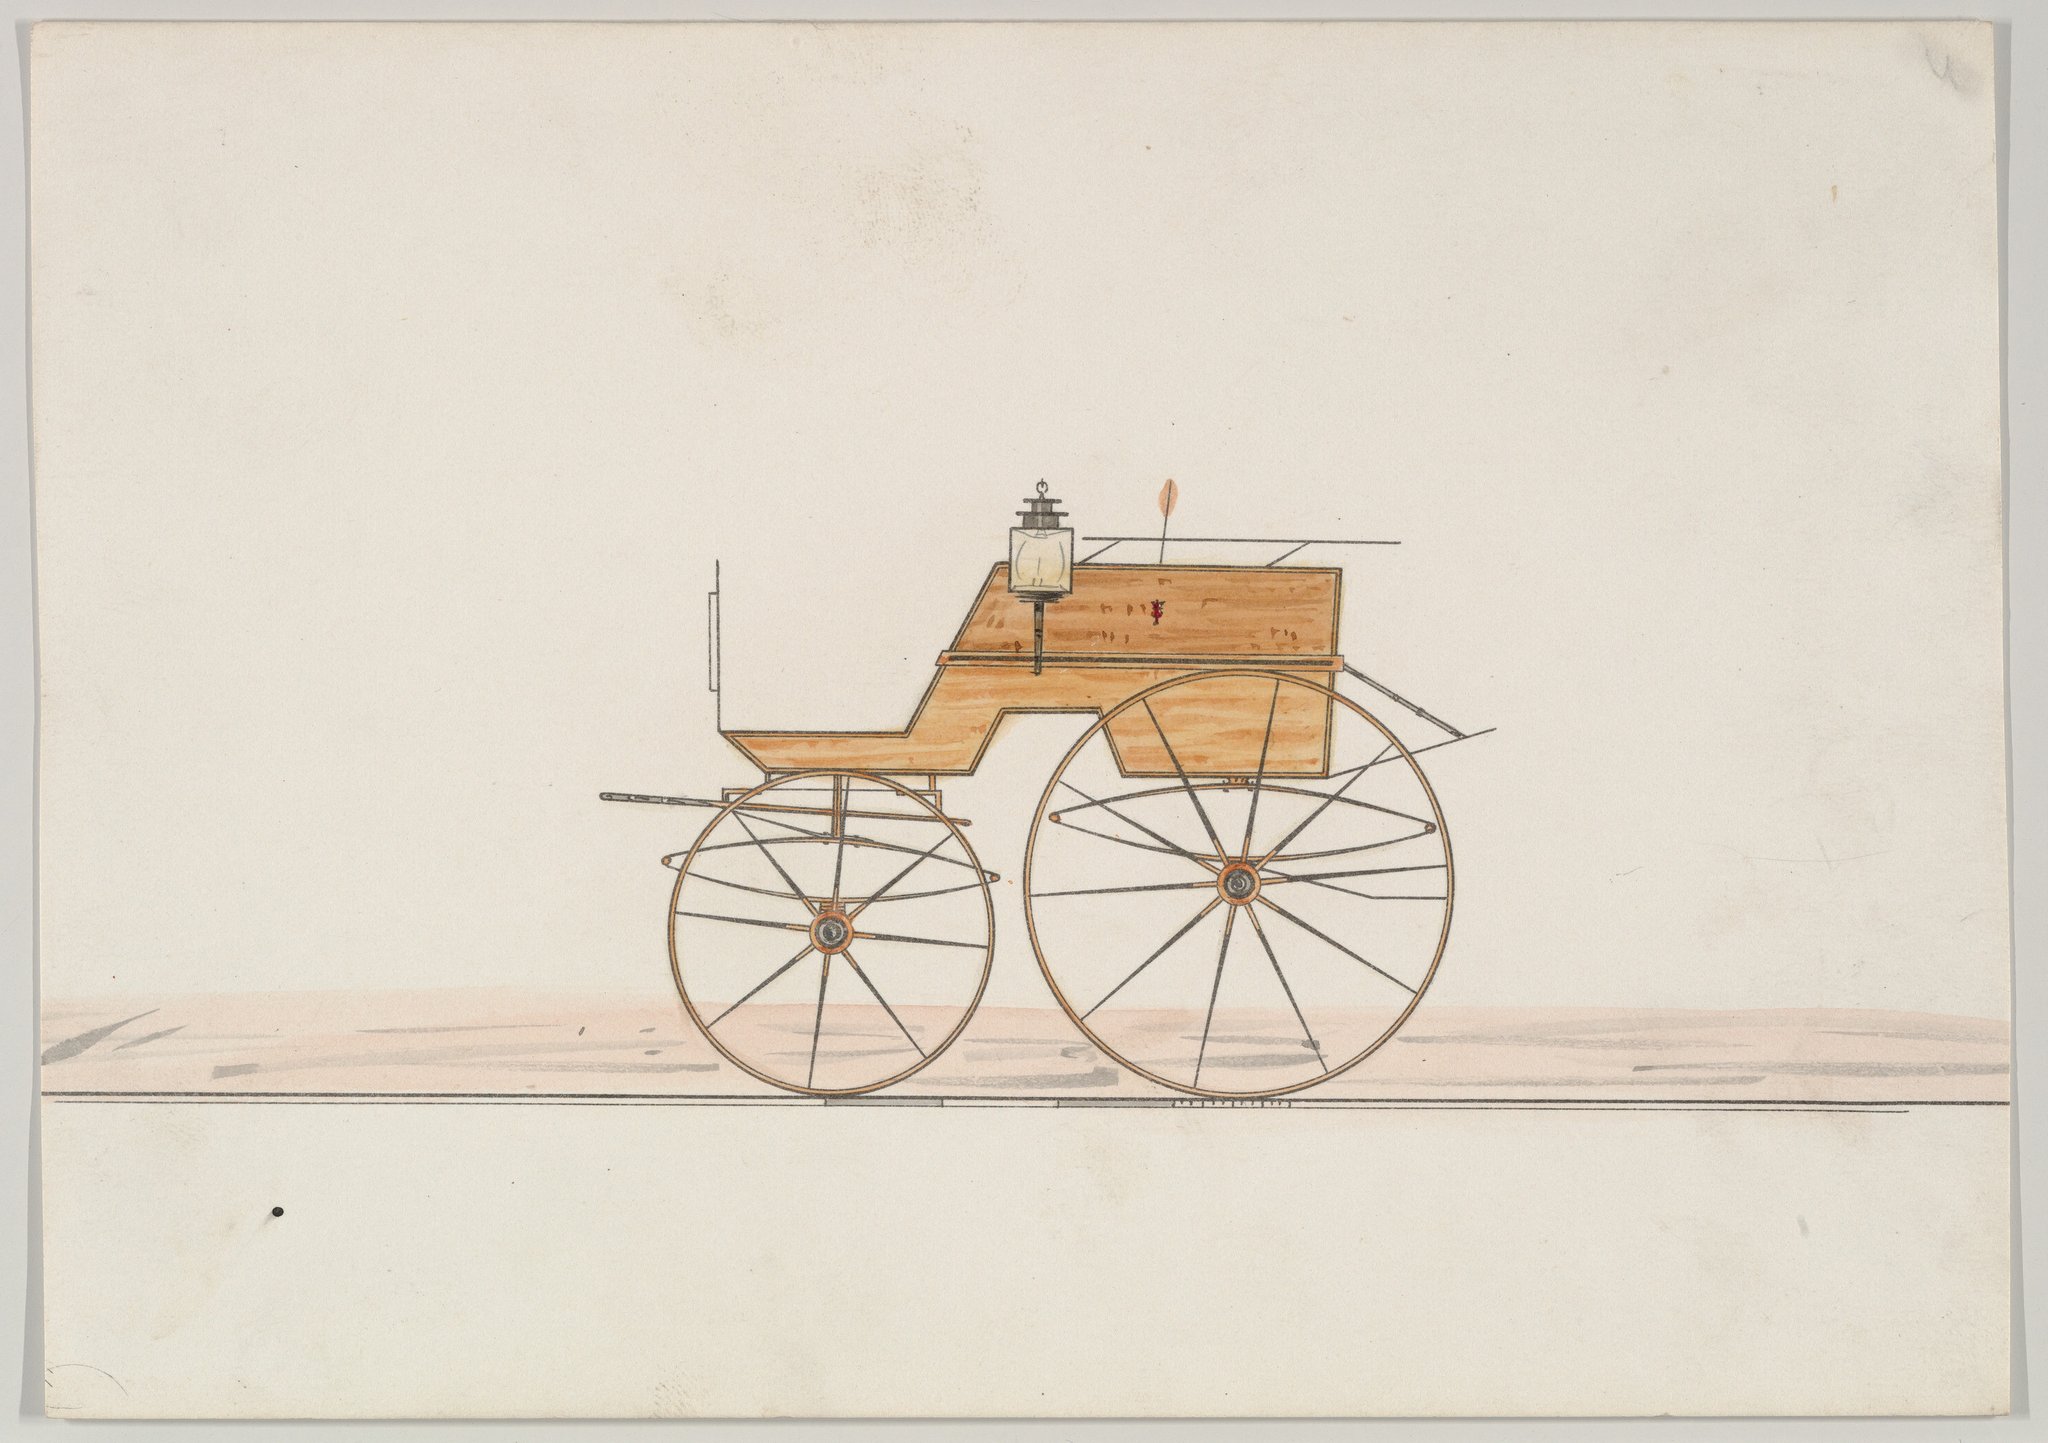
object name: drawing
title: Phaeton (unnumbered)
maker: brewster & co.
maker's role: manufacturer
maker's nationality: american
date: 1850-1870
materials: gouache, gum arabic, ink, watercolor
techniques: pen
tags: carriages